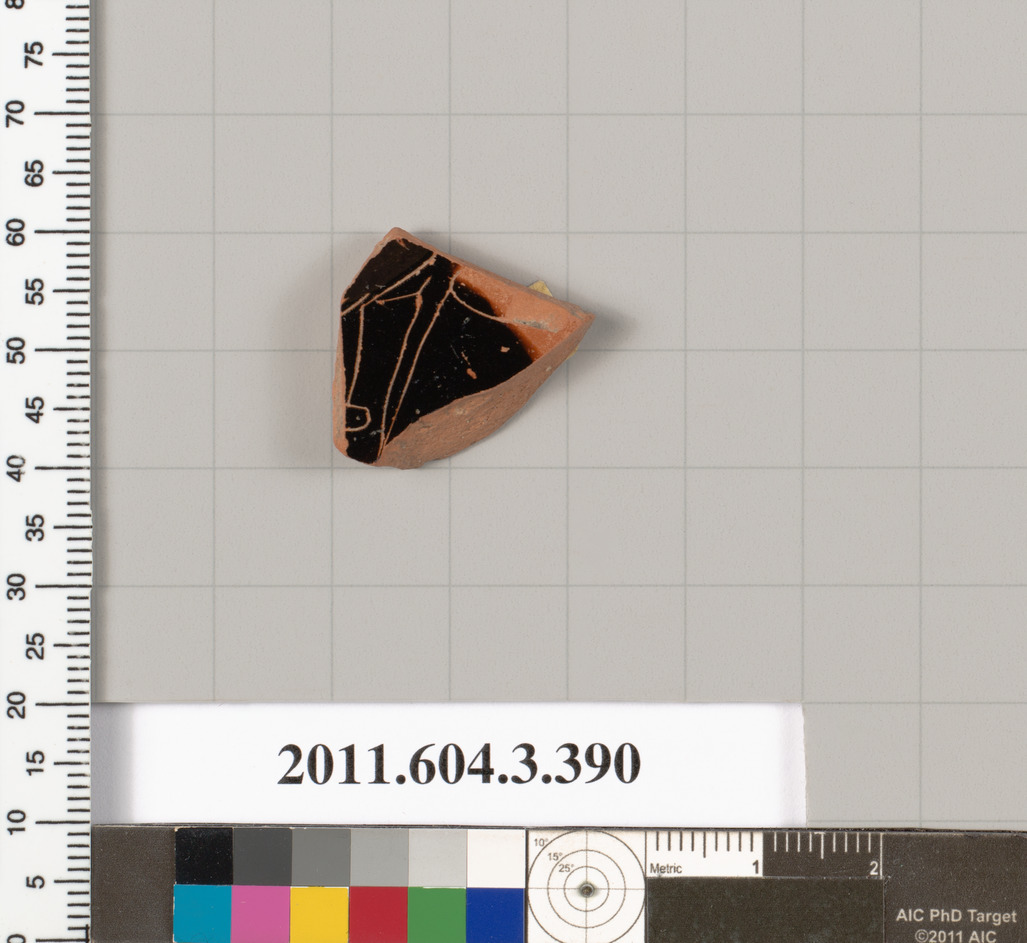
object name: neck amphora fragment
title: Terracotta fragment of a neck-amphora (jar)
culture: greek, attic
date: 525-501 BCE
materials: terracotta